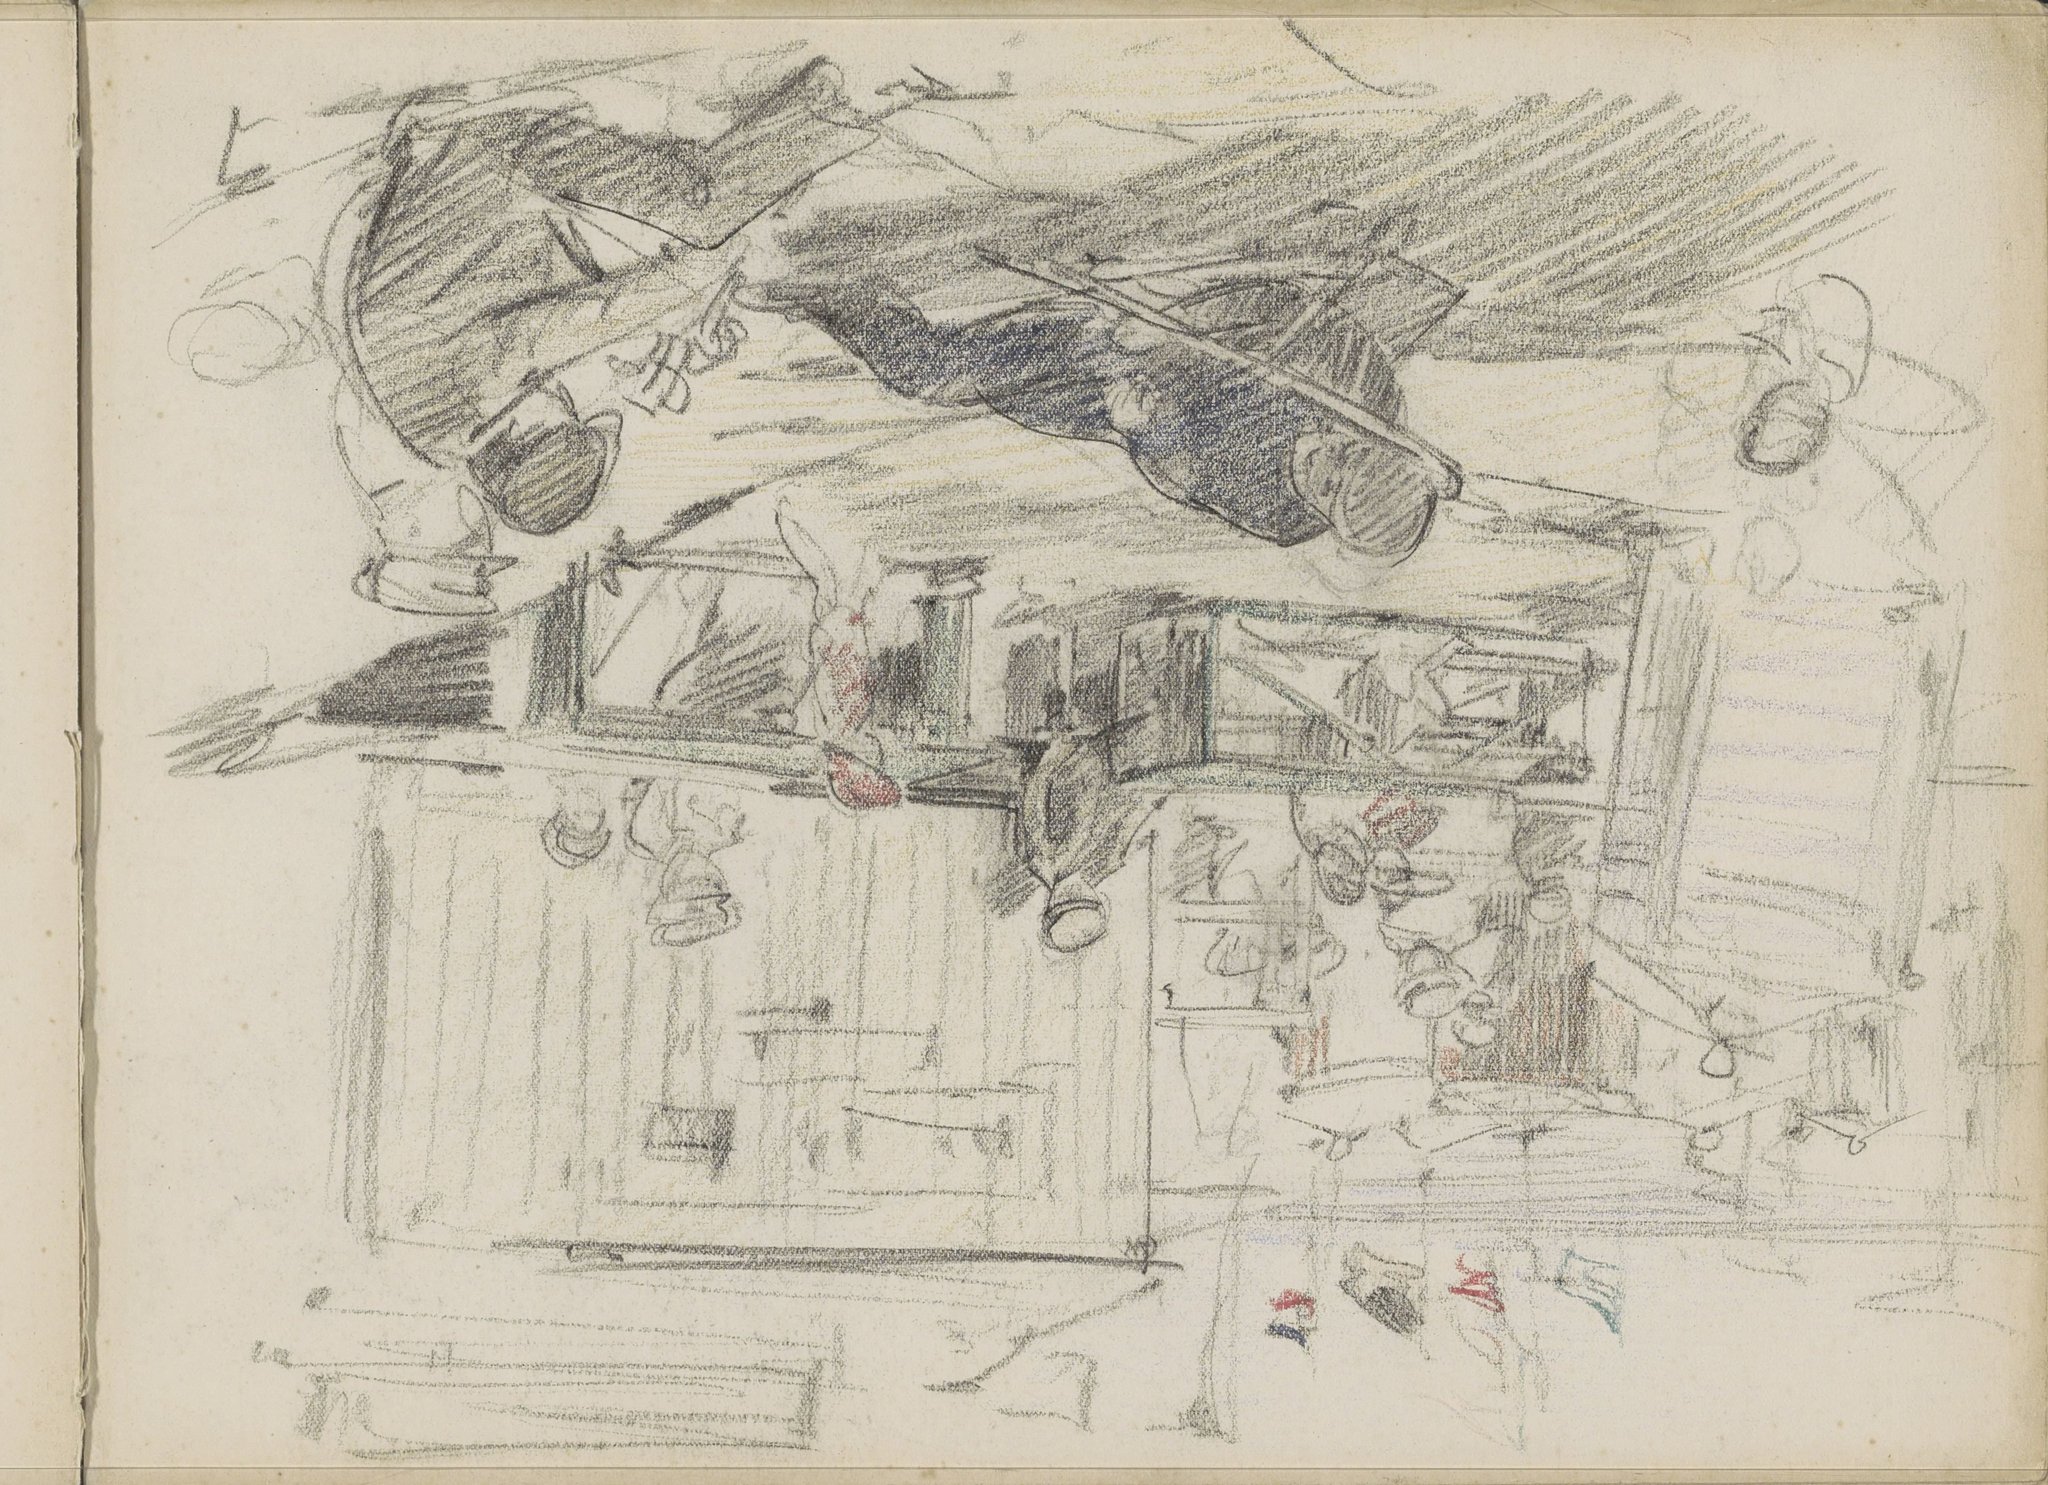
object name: sketchbook leaf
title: Strandgezicht met figuren en kleedhokken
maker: monogrammist ds (tekenaar)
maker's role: draughtsman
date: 1850-1950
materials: chalk, paper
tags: beach (as place of recreation), hut, cabin, lodge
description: Op het strand zit een aantal figuren voor een houten hut. Op de achtergrond een rij kleedhokken met vlaggen erop. Op de voorgrond slaapt een man in een ligstoel. Blad 11 recto uit een schetsboek met 17 bladen.